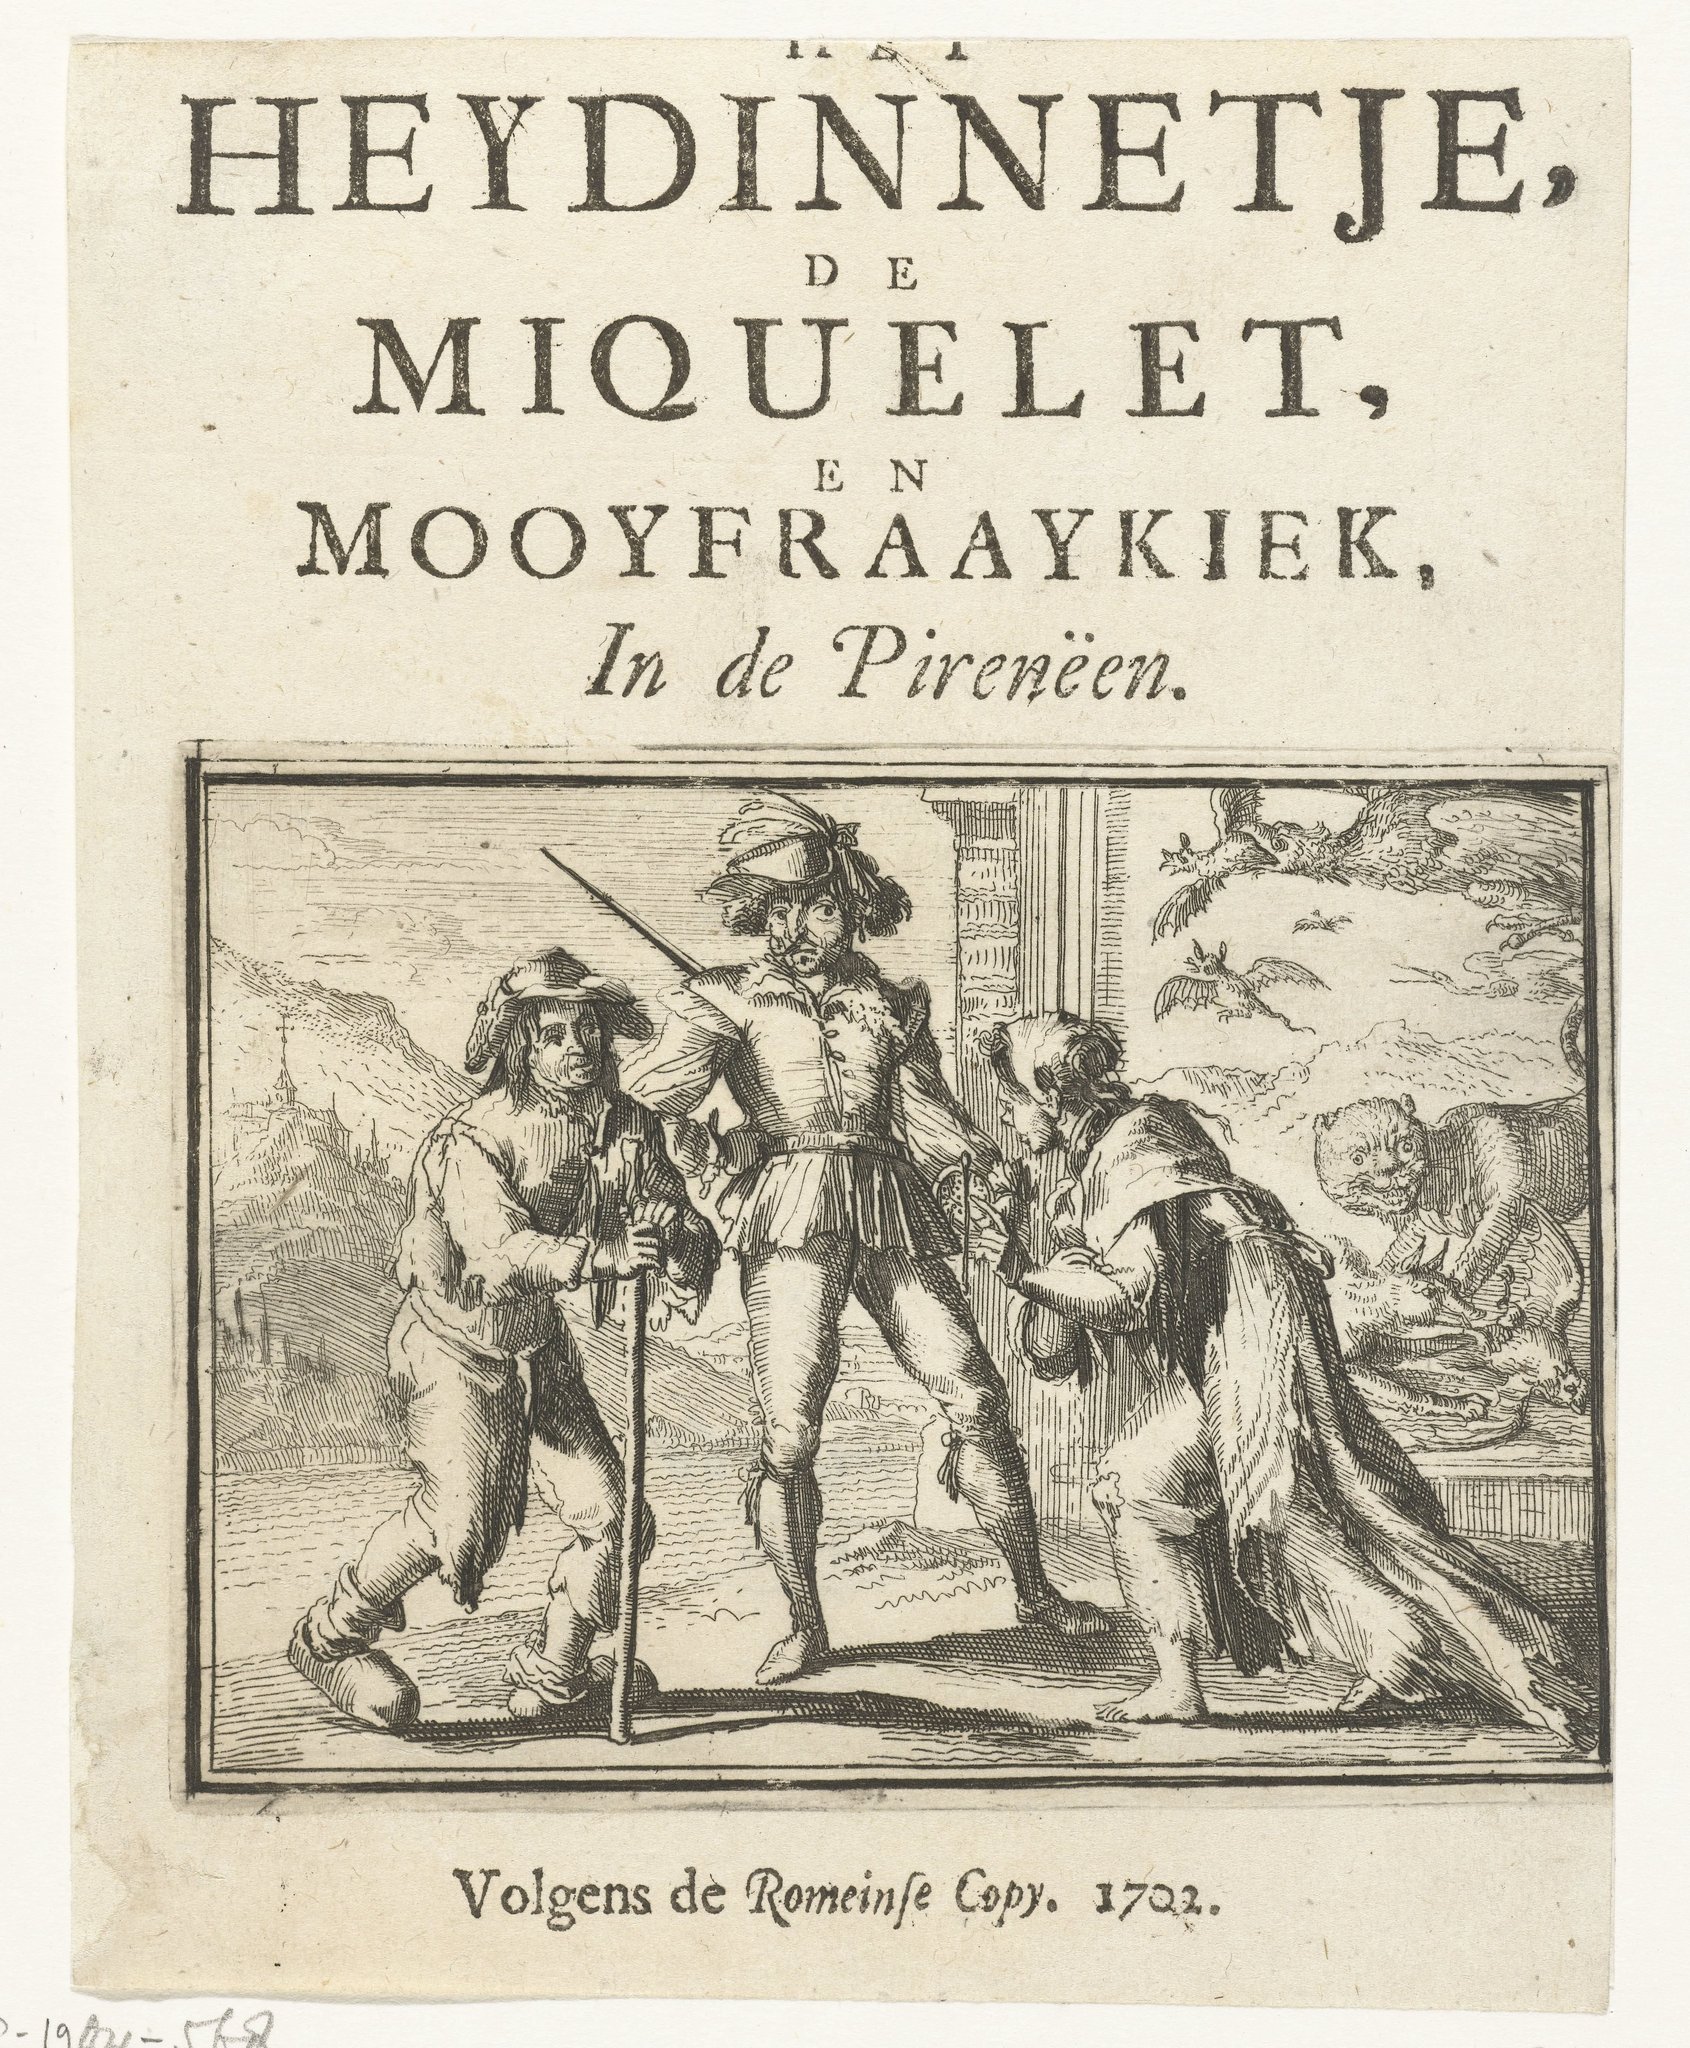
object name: print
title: Esopus in Europa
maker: romeyn de hooghe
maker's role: draughtsman, goldsmith, painter, print maker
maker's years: 1645-1708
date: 1702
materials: paper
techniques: etching, letterpress printing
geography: northern netherlands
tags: wandering communities: romani or roma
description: Titelblad voor het pamflet: Het Heydinnetje, de Miquelet, en Mooyfraaykiek, In de Pirenëen, 1702. Soldaat (Savoye) staande tussen een bedelaar en een heidinnetje (zigeunerin), beiden in lompen.